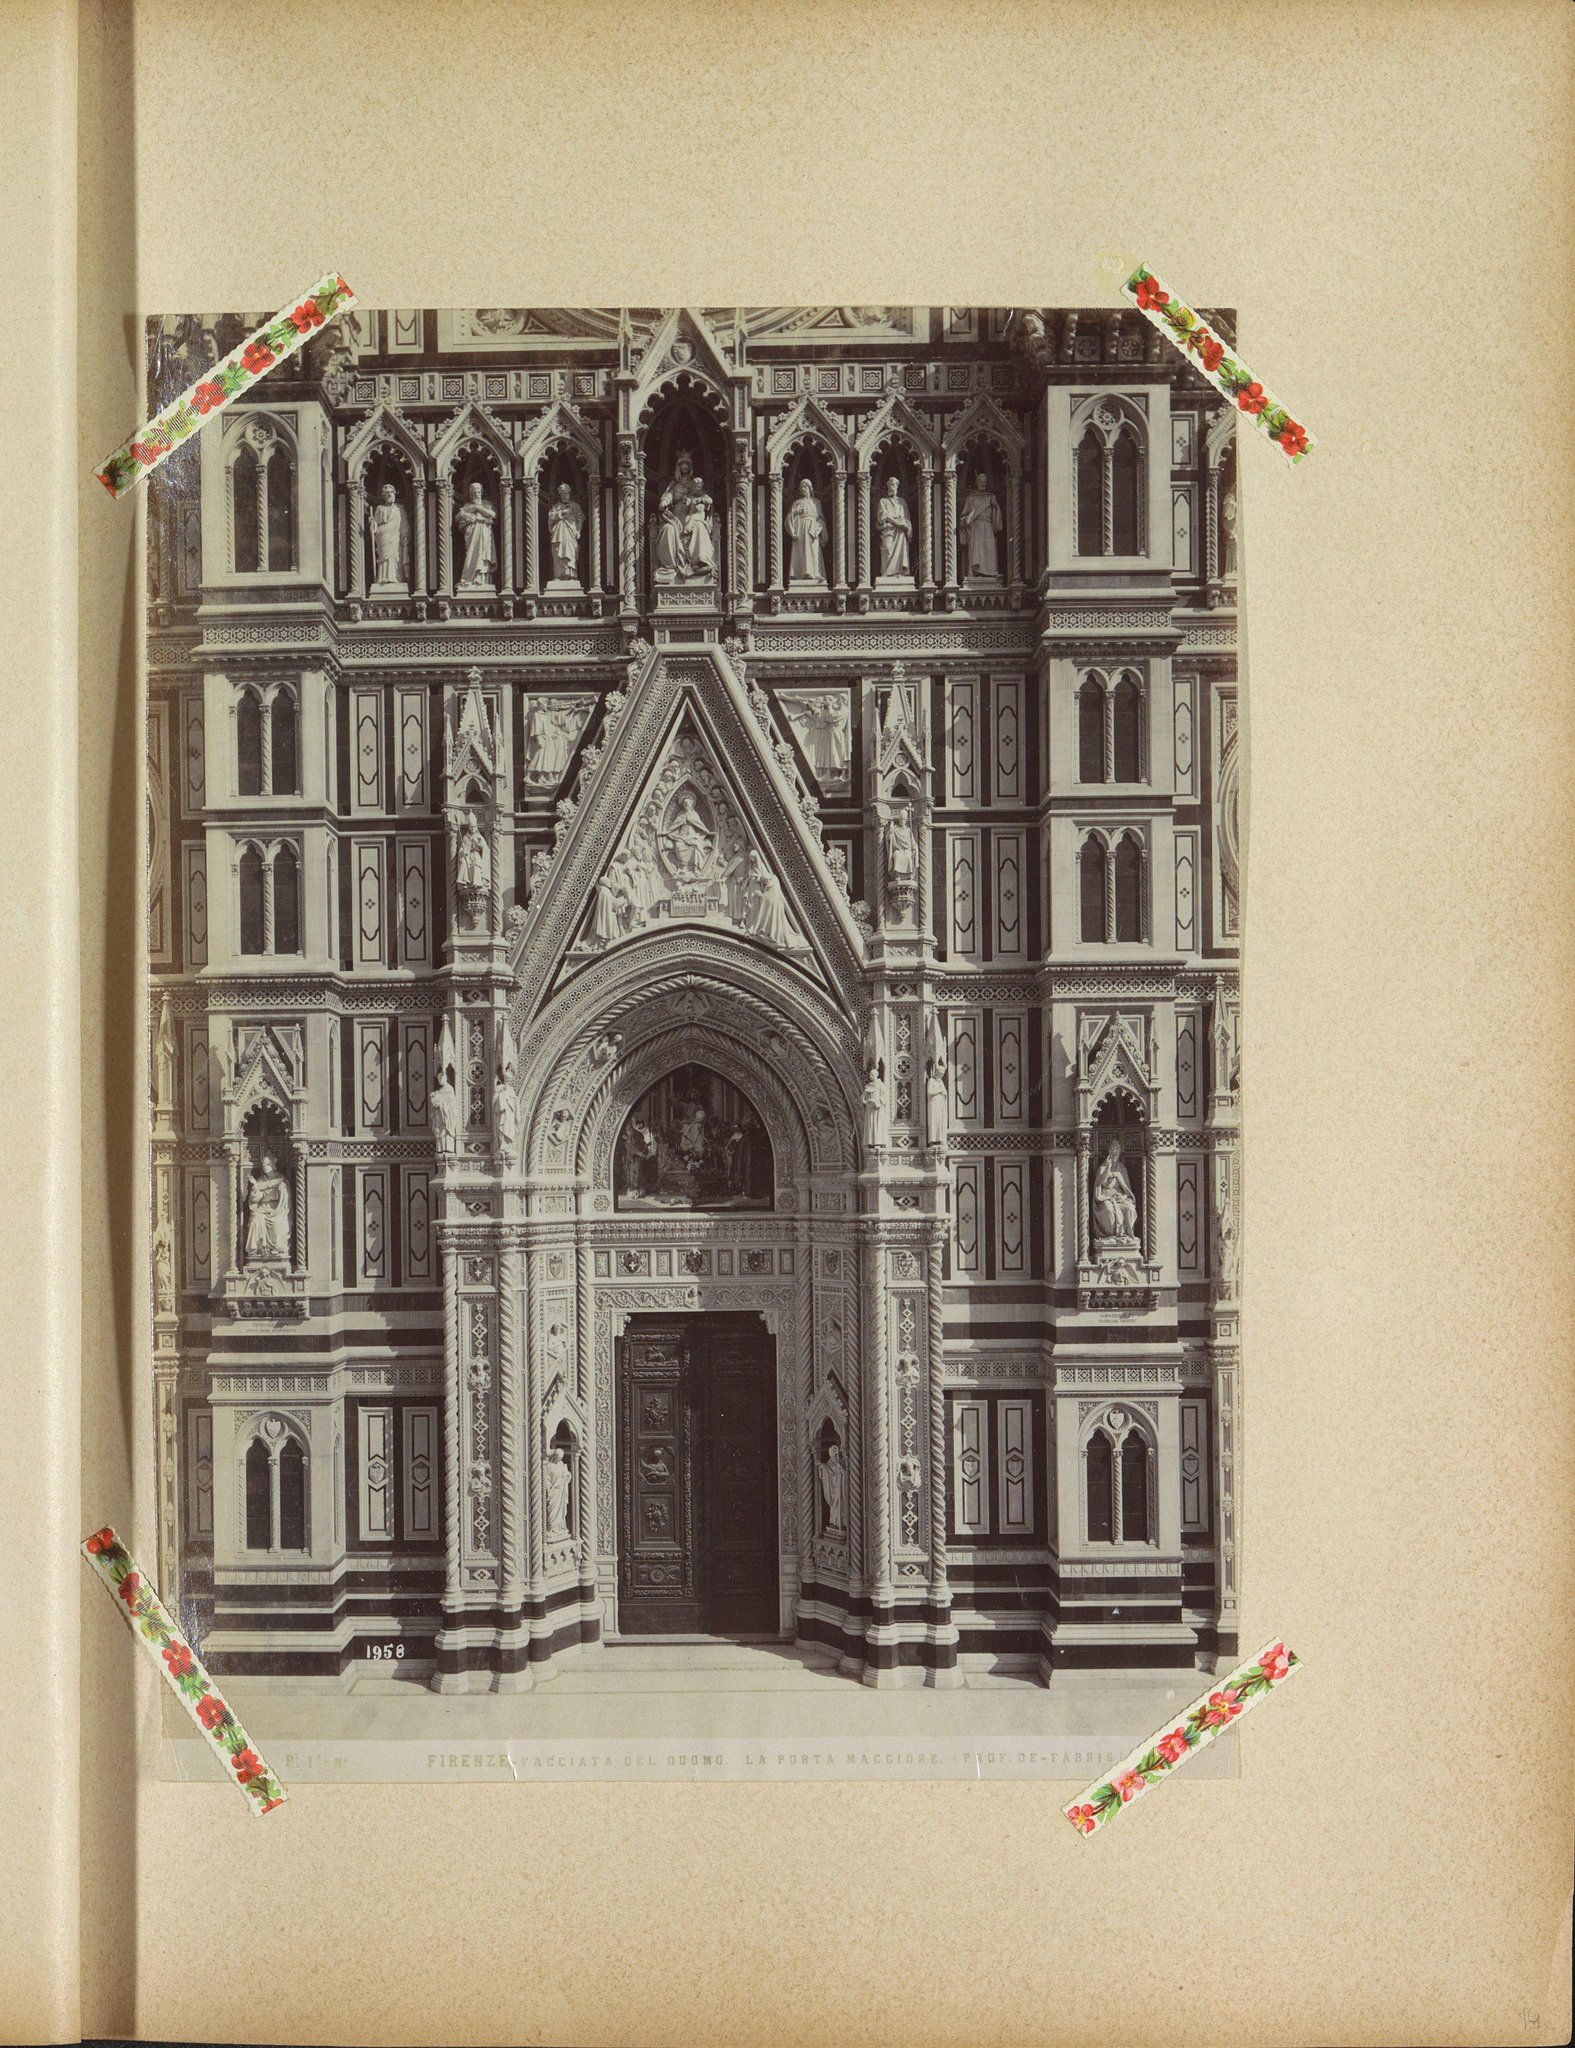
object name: photograph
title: Hoofdportaal van de kathedraal van Florence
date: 1860-1900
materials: photographic support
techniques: albumen print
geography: florence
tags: parts of church exterior and annexes: portal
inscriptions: number: ‘1958’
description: Onderdeel van Fotoalbum met opnames van bezienswaardigheden in Italiaanse steden en van kunstwerken.